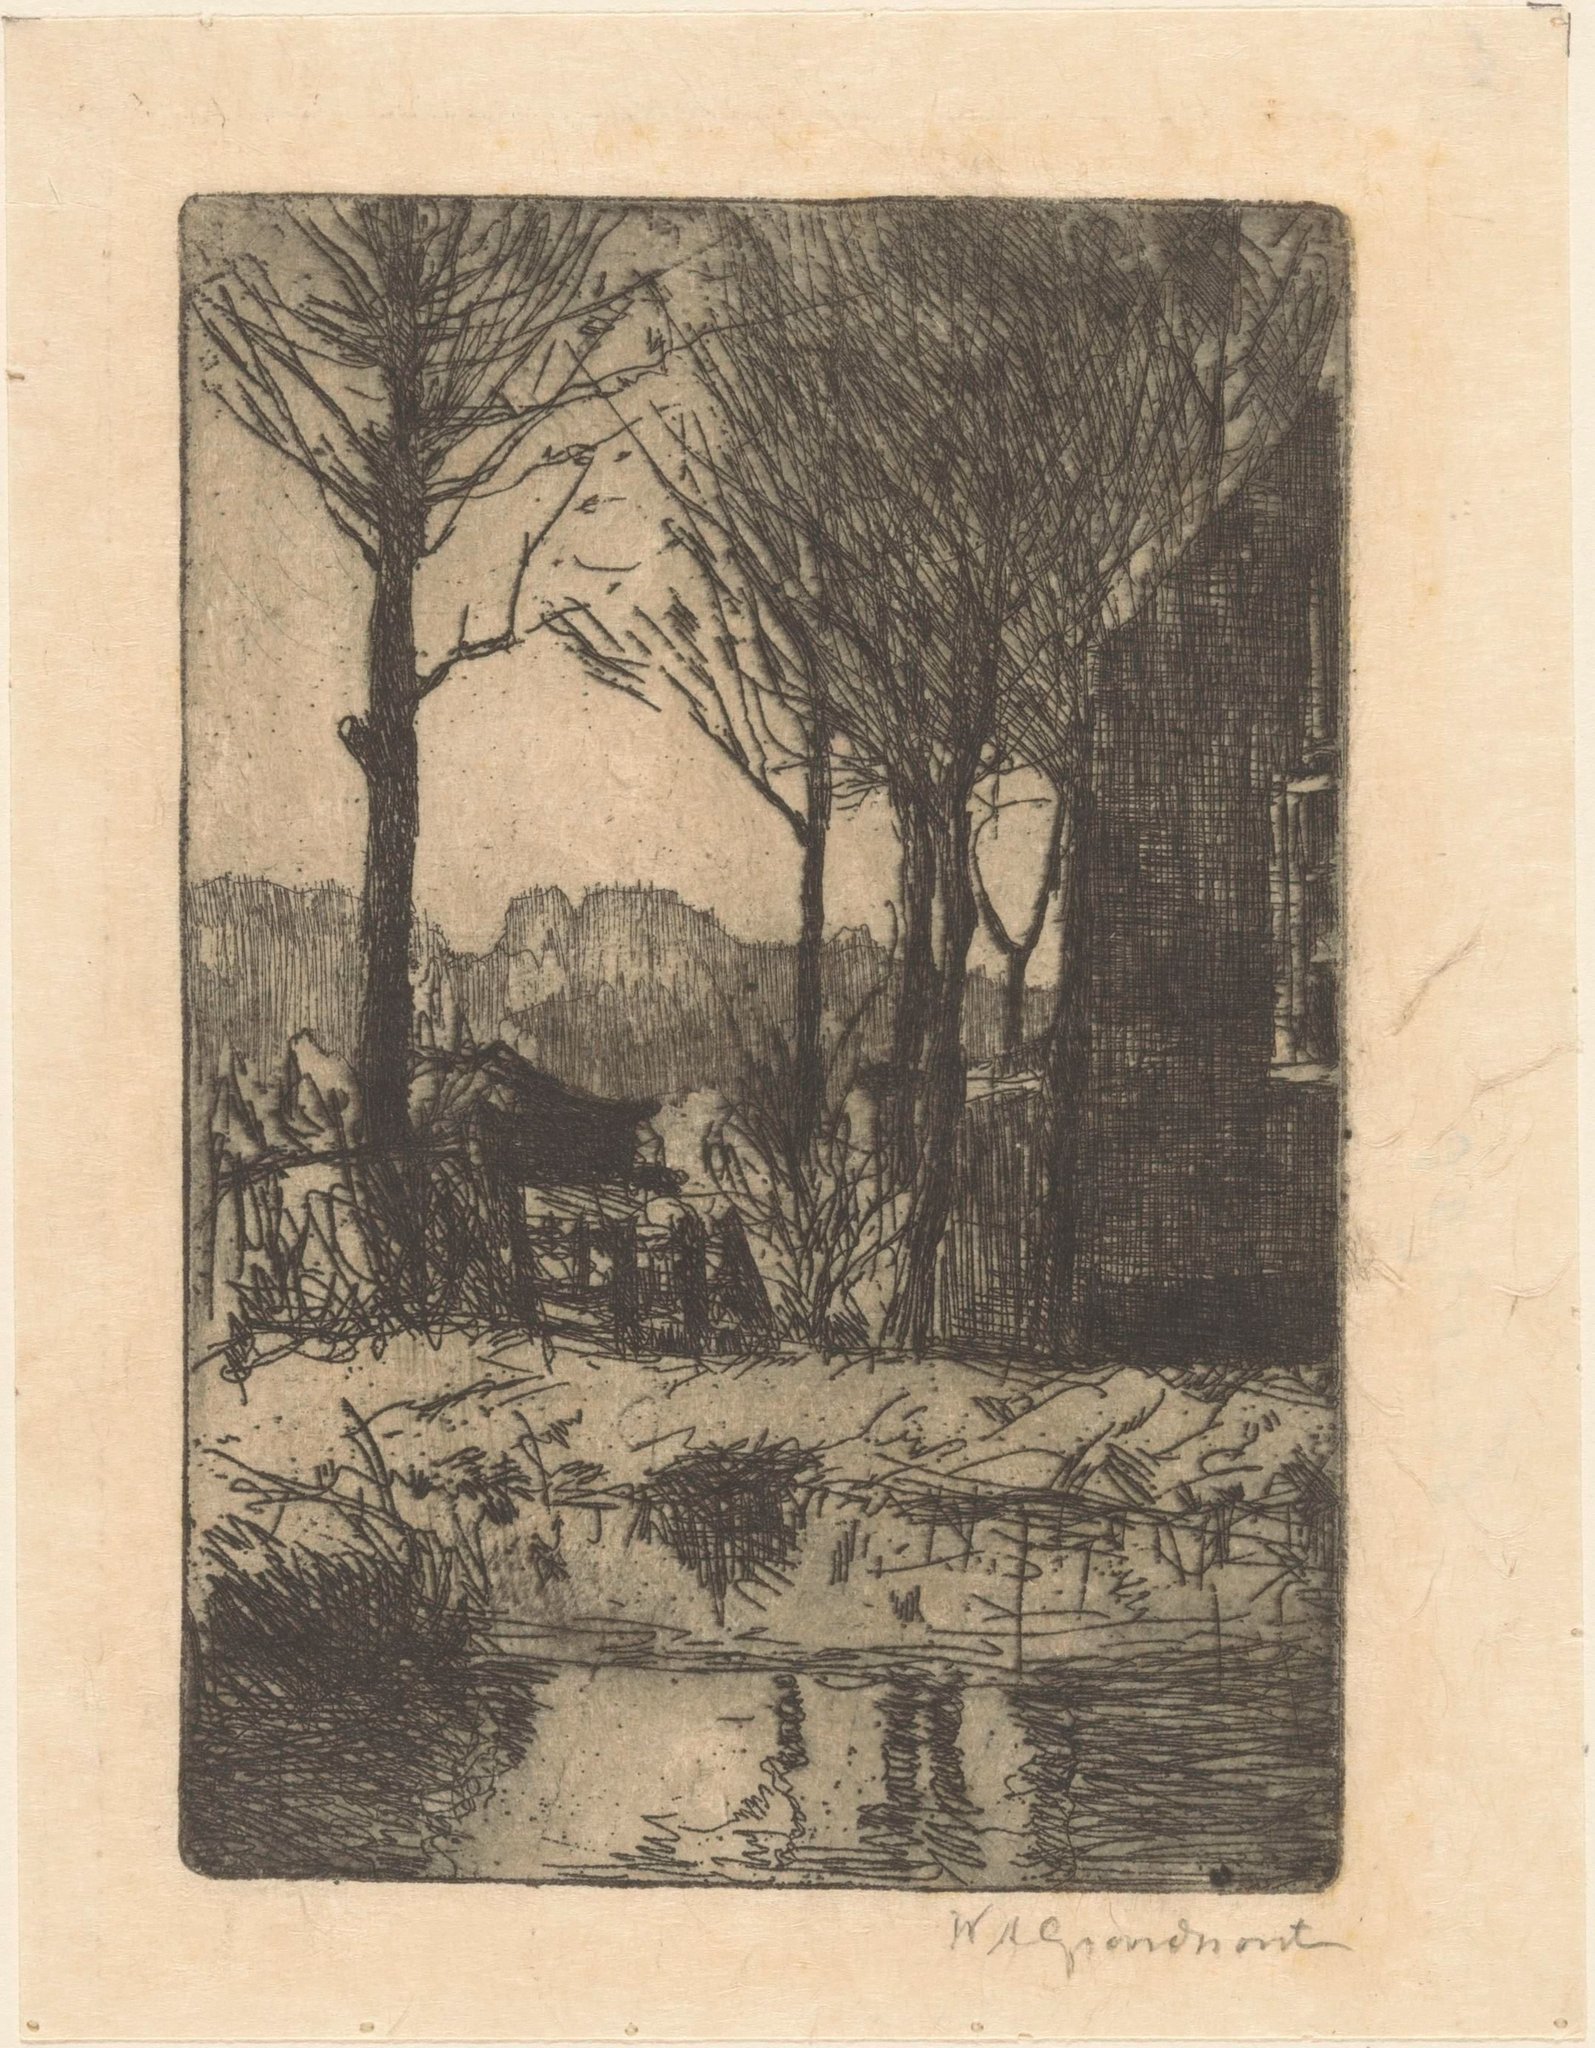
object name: print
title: Huis aan het water in de Binckhorst in Den Haag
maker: willem adrianus grondhout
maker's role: draughtsman, painter, print maker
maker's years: 1878-1934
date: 1888-1934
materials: paper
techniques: etching, intaglio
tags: civic architecture; edifices; dwellings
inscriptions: collector's mark: Lugt 2228